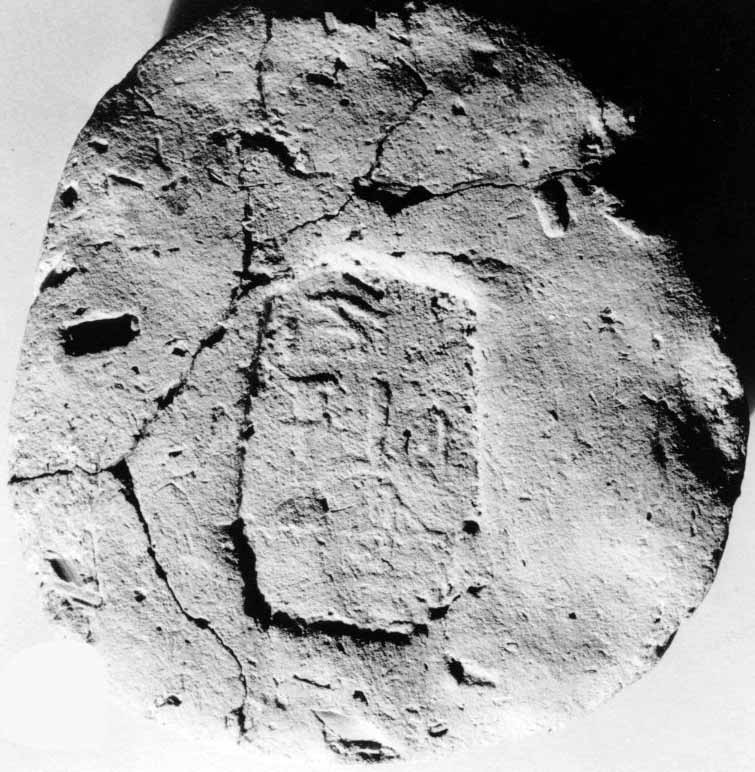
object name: cone, abekh, oval impression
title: Funerary Cone of the Steward Abekh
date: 1550-1295 BCE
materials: pottery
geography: egypt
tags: hieroglyphs